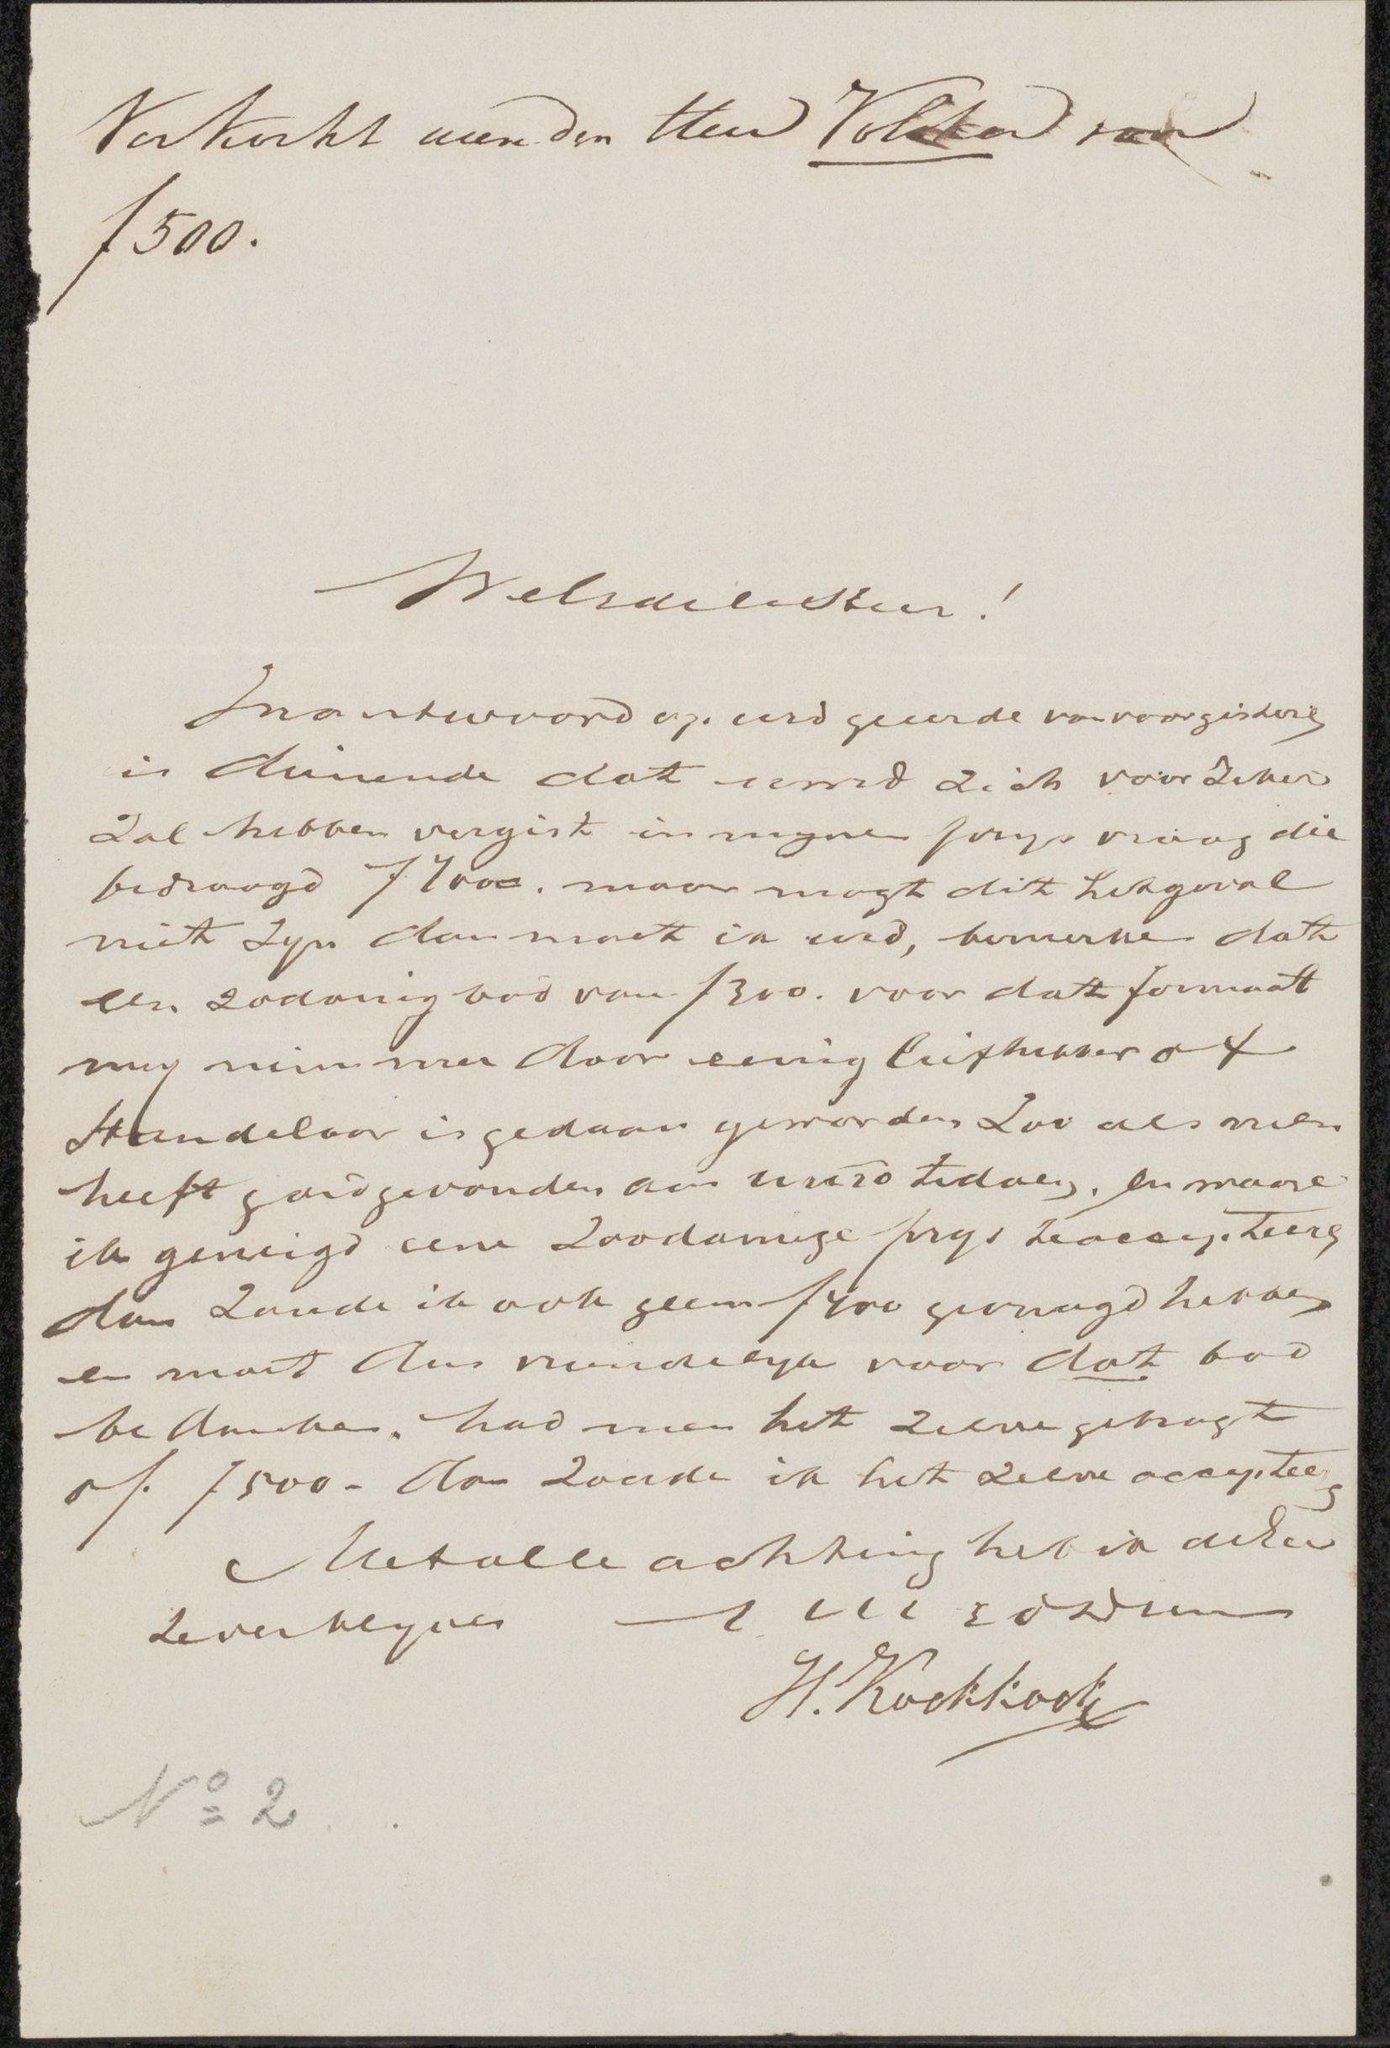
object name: letter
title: Brief aan anoniem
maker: hermanus koekkoek (i)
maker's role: draughtsman, painter, print maker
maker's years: 1815-1882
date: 1825-1882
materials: ink, paper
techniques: pen, writing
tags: art trade, art shop, money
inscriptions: collector's mark: Lugt 2233